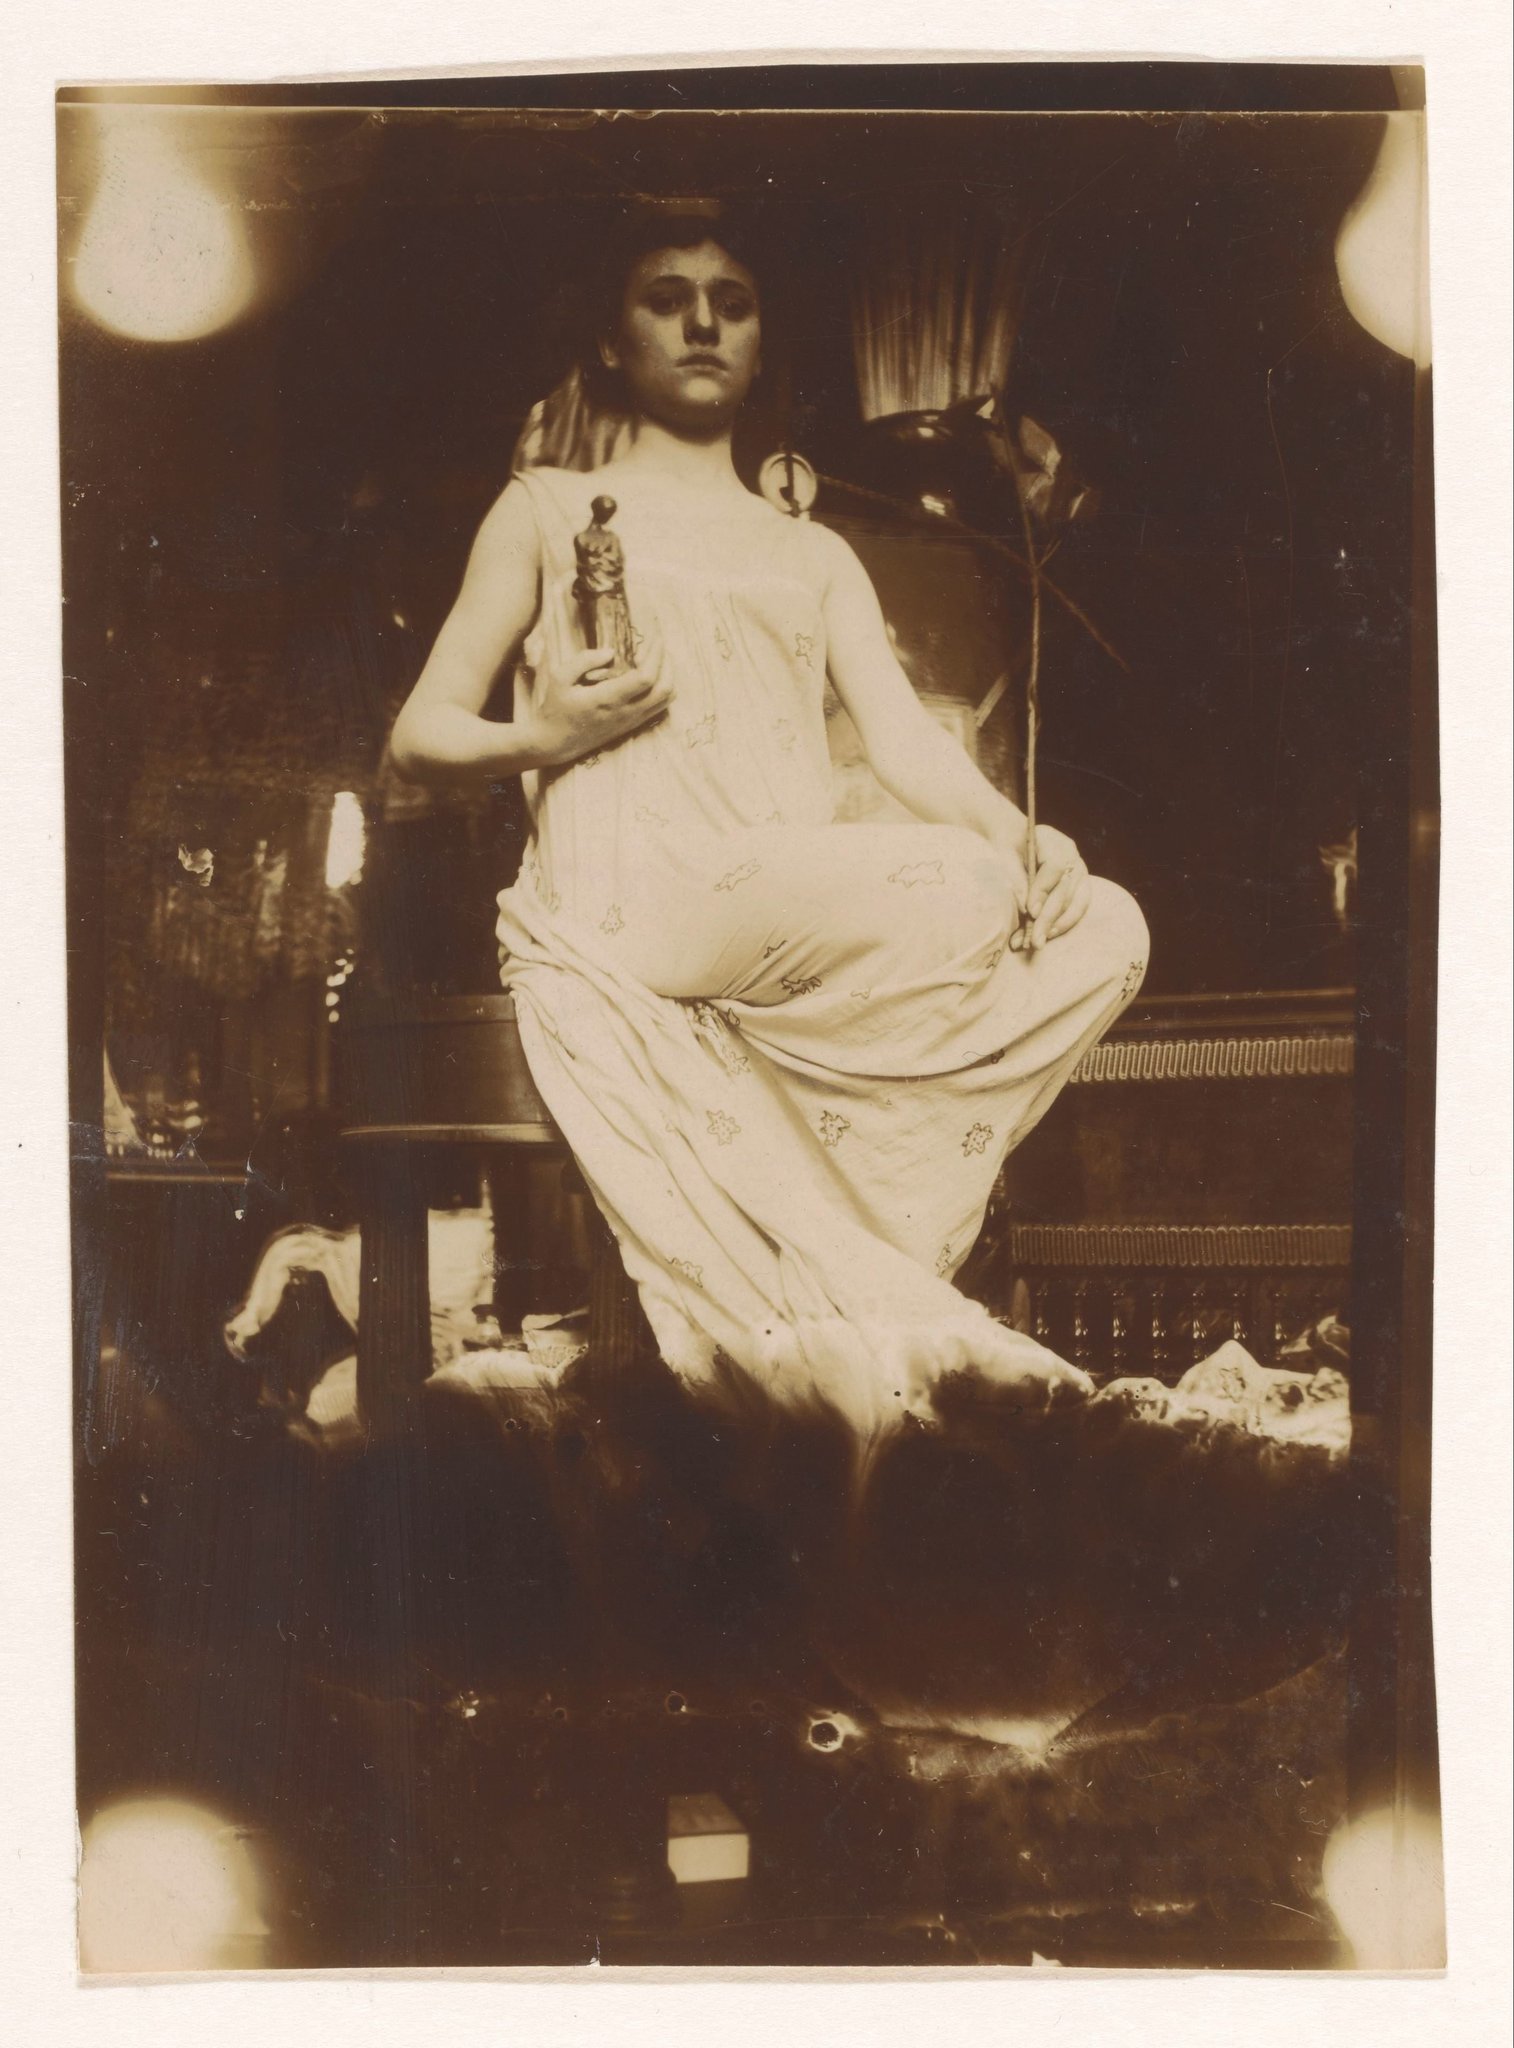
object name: photograph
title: Vrouw zittend op een verhoging met een figurine in haar handen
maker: alfons maria mucha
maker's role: designer, painter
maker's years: 1860-1939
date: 1895-1905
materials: photographic support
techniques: gelatin silver print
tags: adult woman, miniature imitations (children's games and plays)